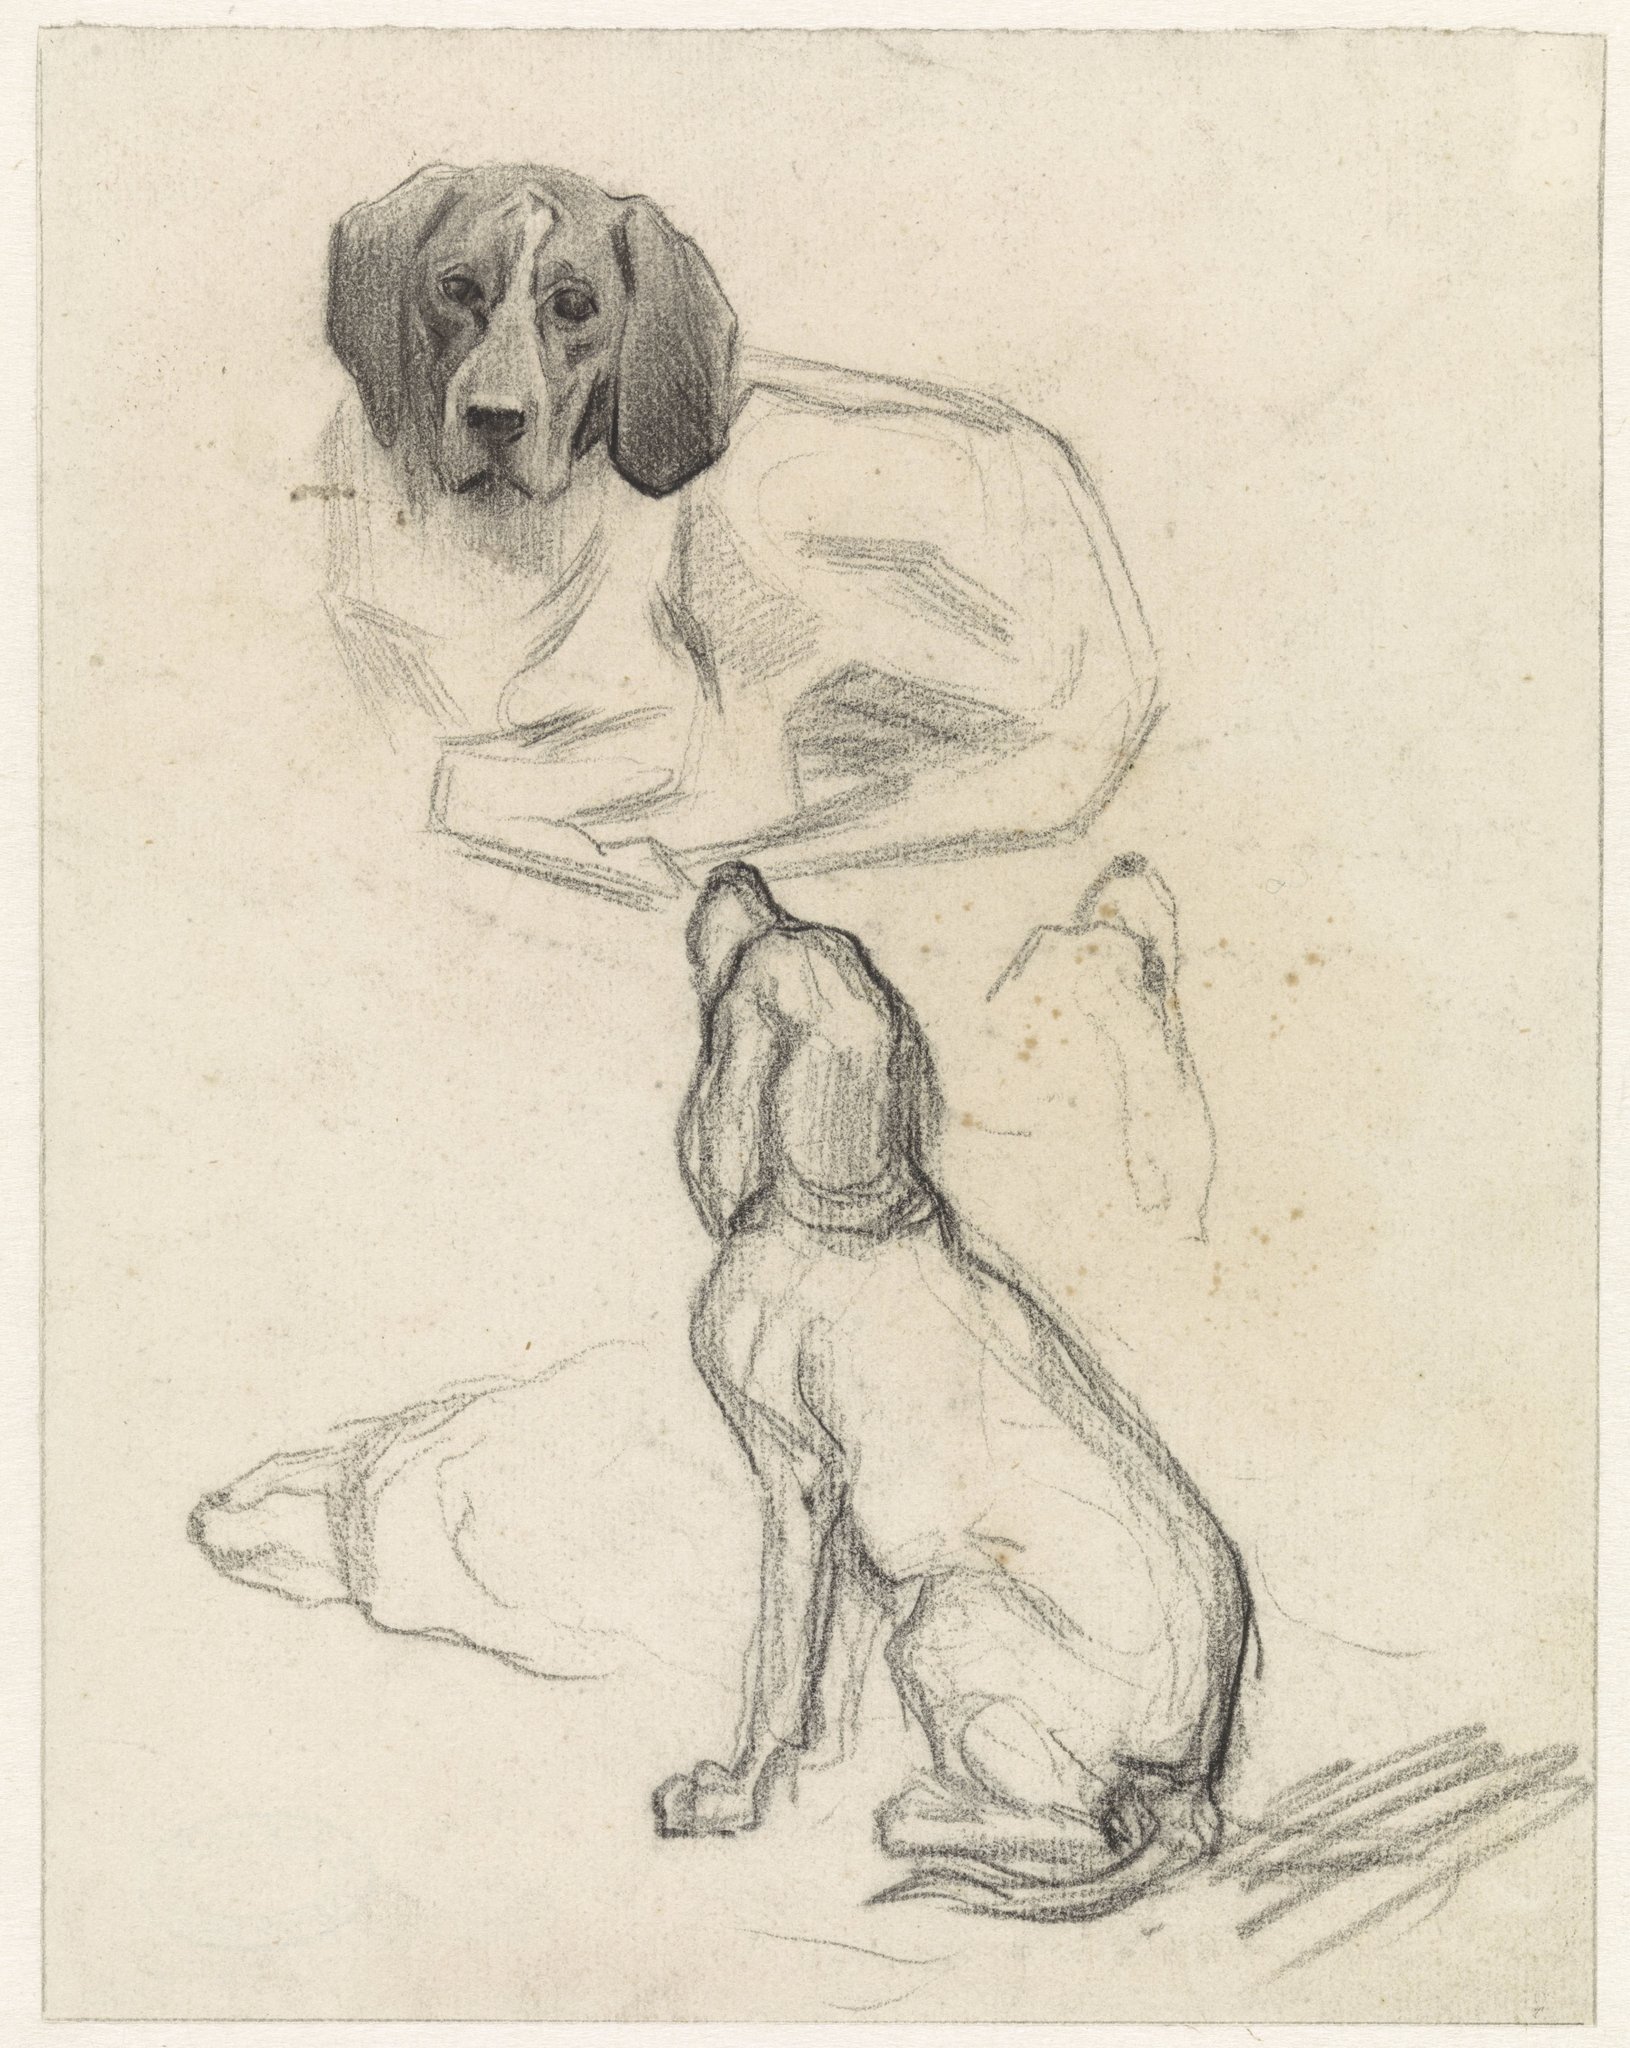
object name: drawing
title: Sheet of Studies of Dogs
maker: jan van essen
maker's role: draughtsman, print maker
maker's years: 1854-1936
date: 1900-1925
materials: chalk, paper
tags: dog